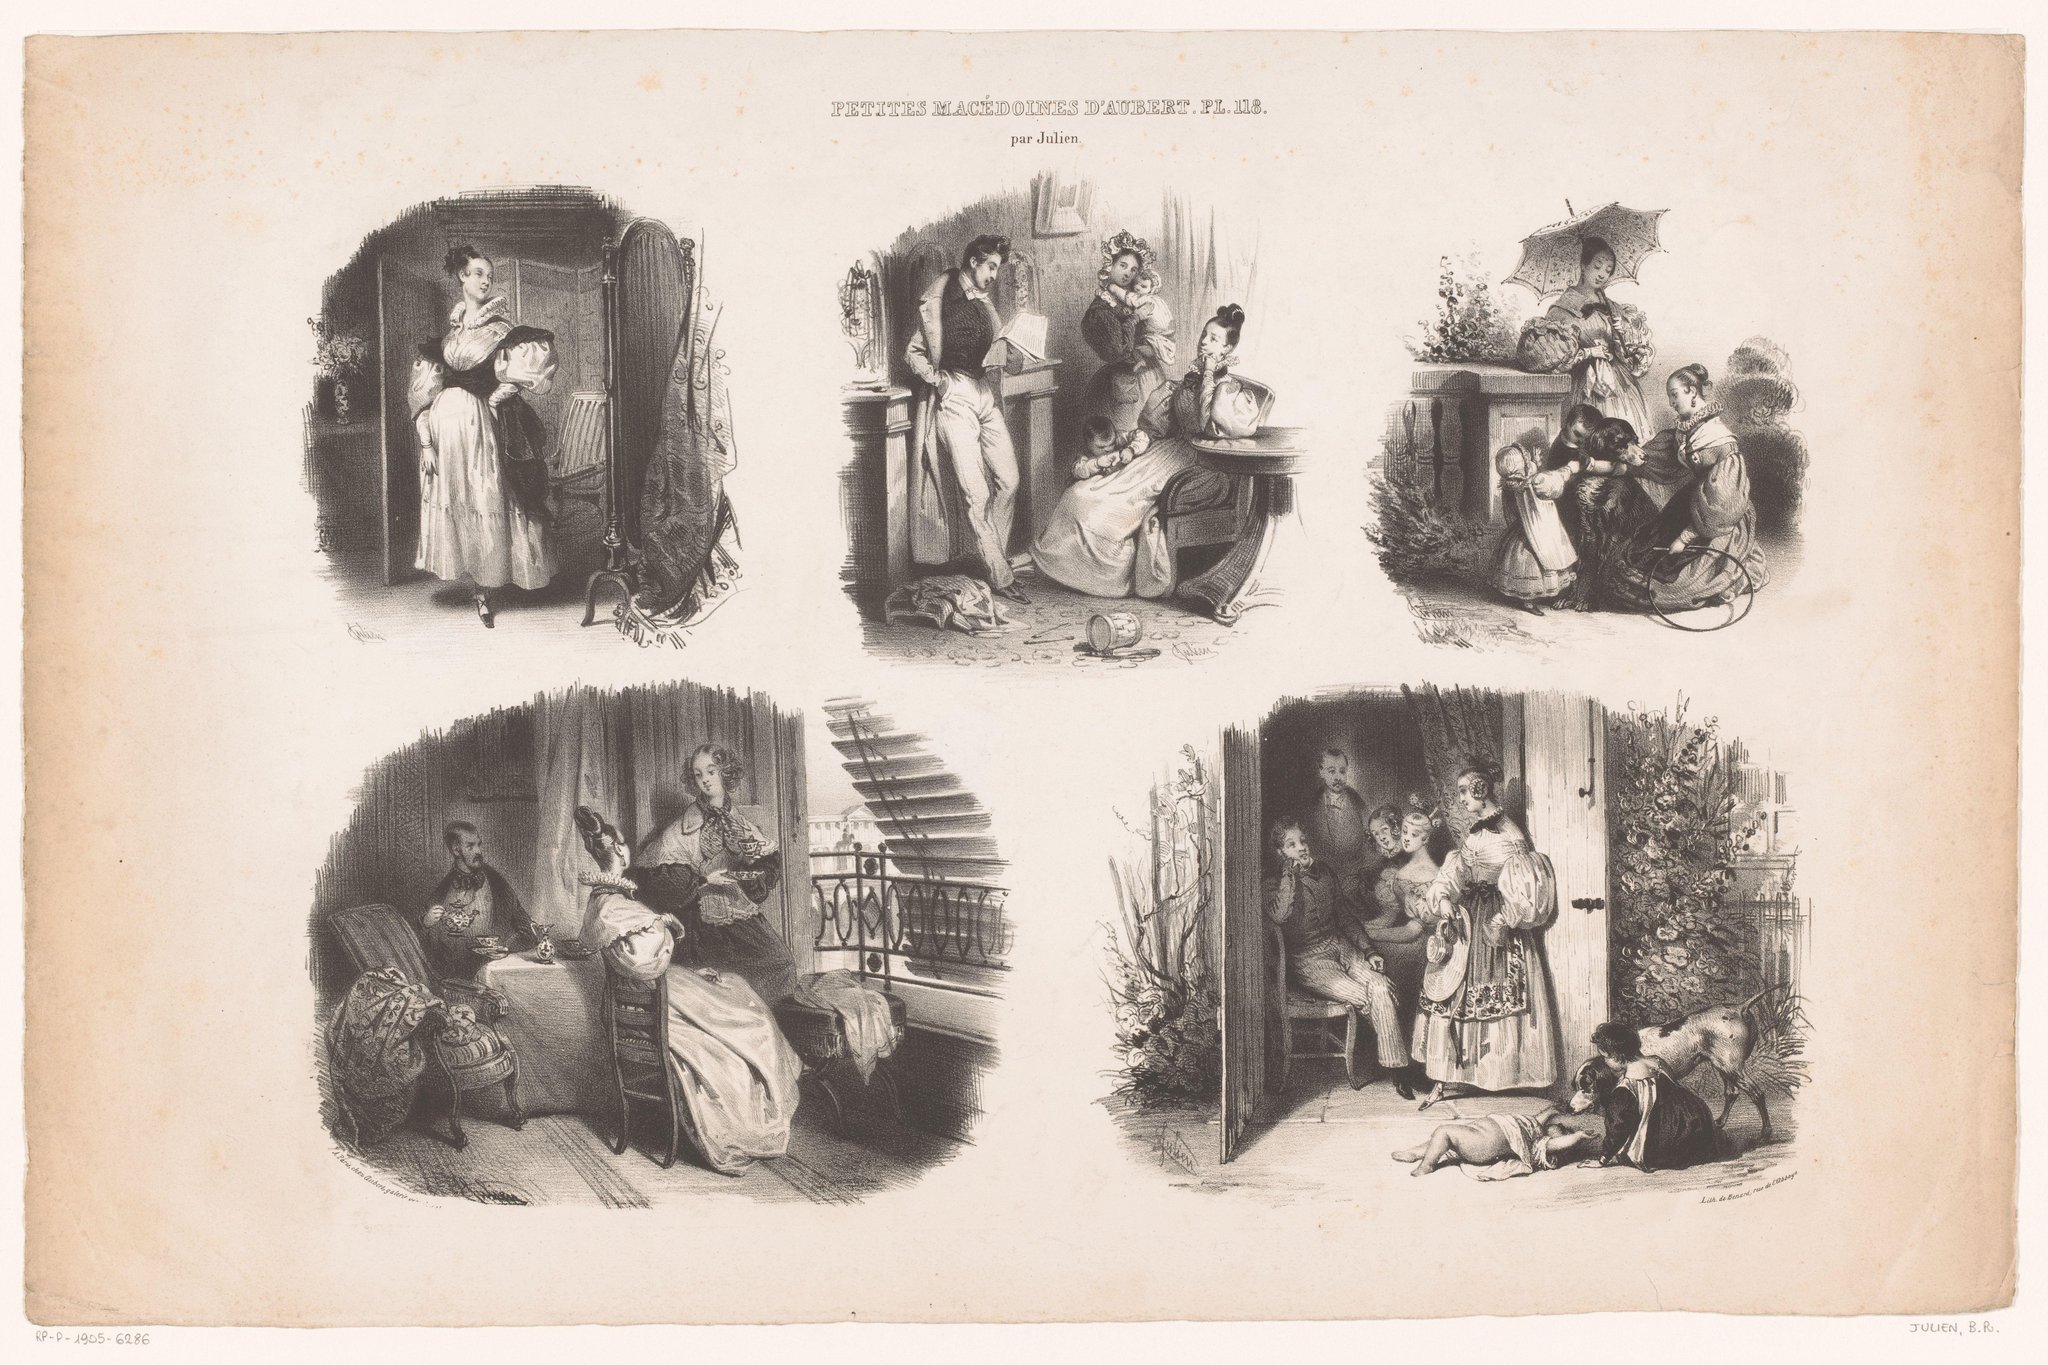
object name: print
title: Petites macédoines d'Aubert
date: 1832-1833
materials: paper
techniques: lithograph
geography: paris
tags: garden, interior of the house, family life at home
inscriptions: collector's mark: Lugt 2228a